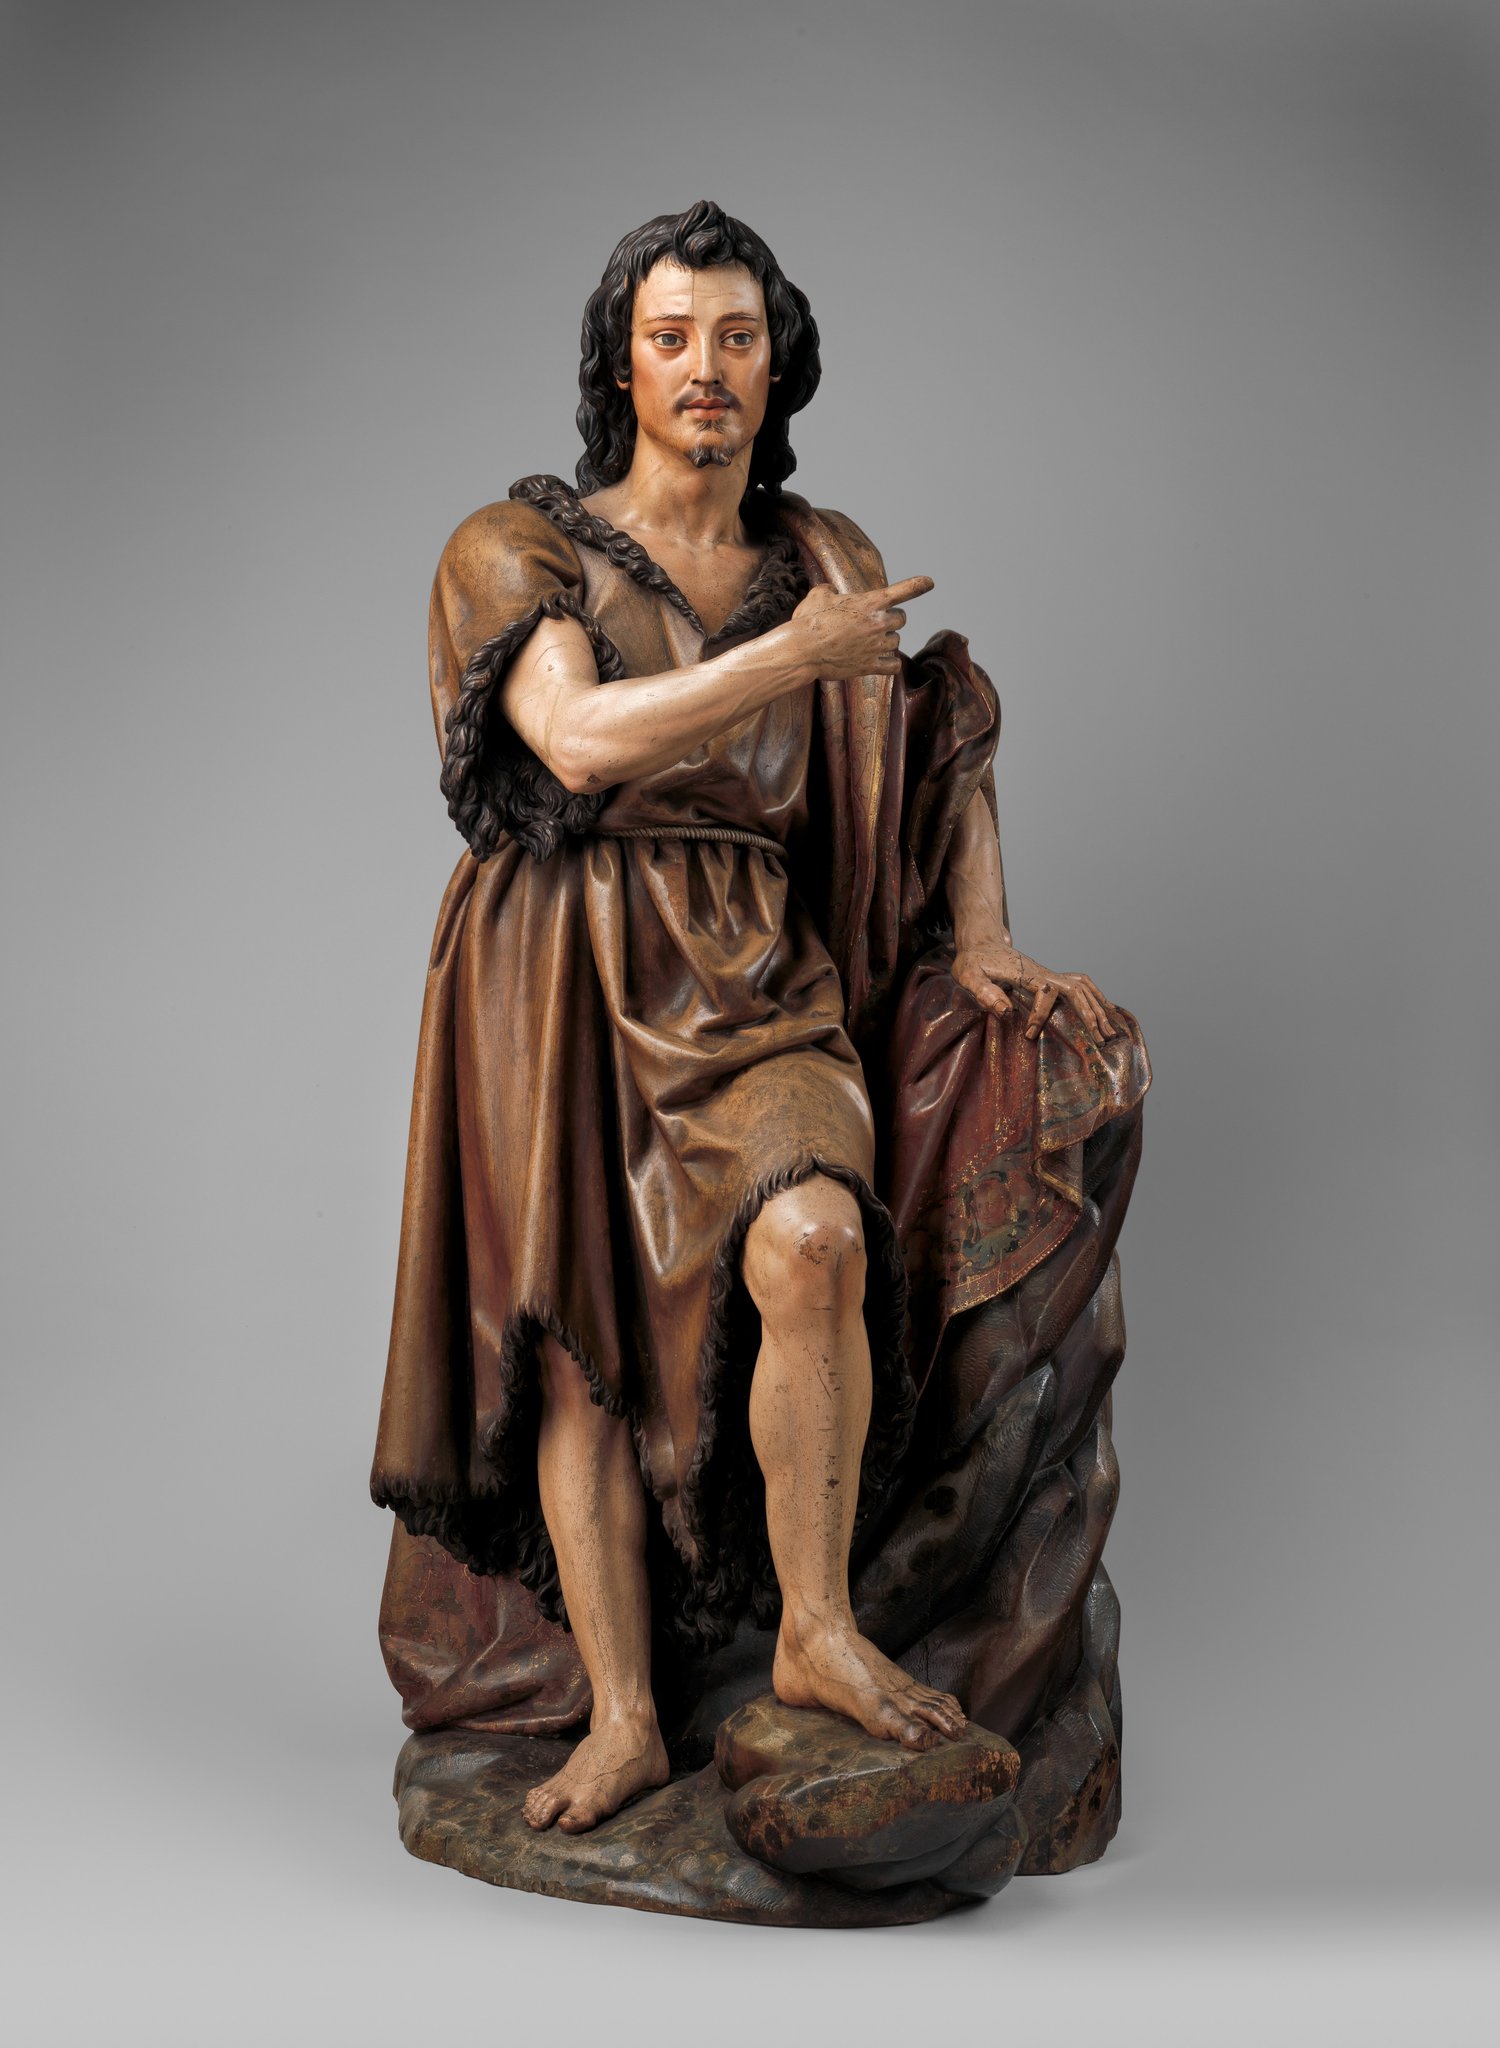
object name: statue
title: Saint John the Baptist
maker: juan martínez montañés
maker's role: artist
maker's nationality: spanish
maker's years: 1568-1649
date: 1620-1630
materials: wood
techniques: gilding, polychrome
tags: men,saint john the baptist